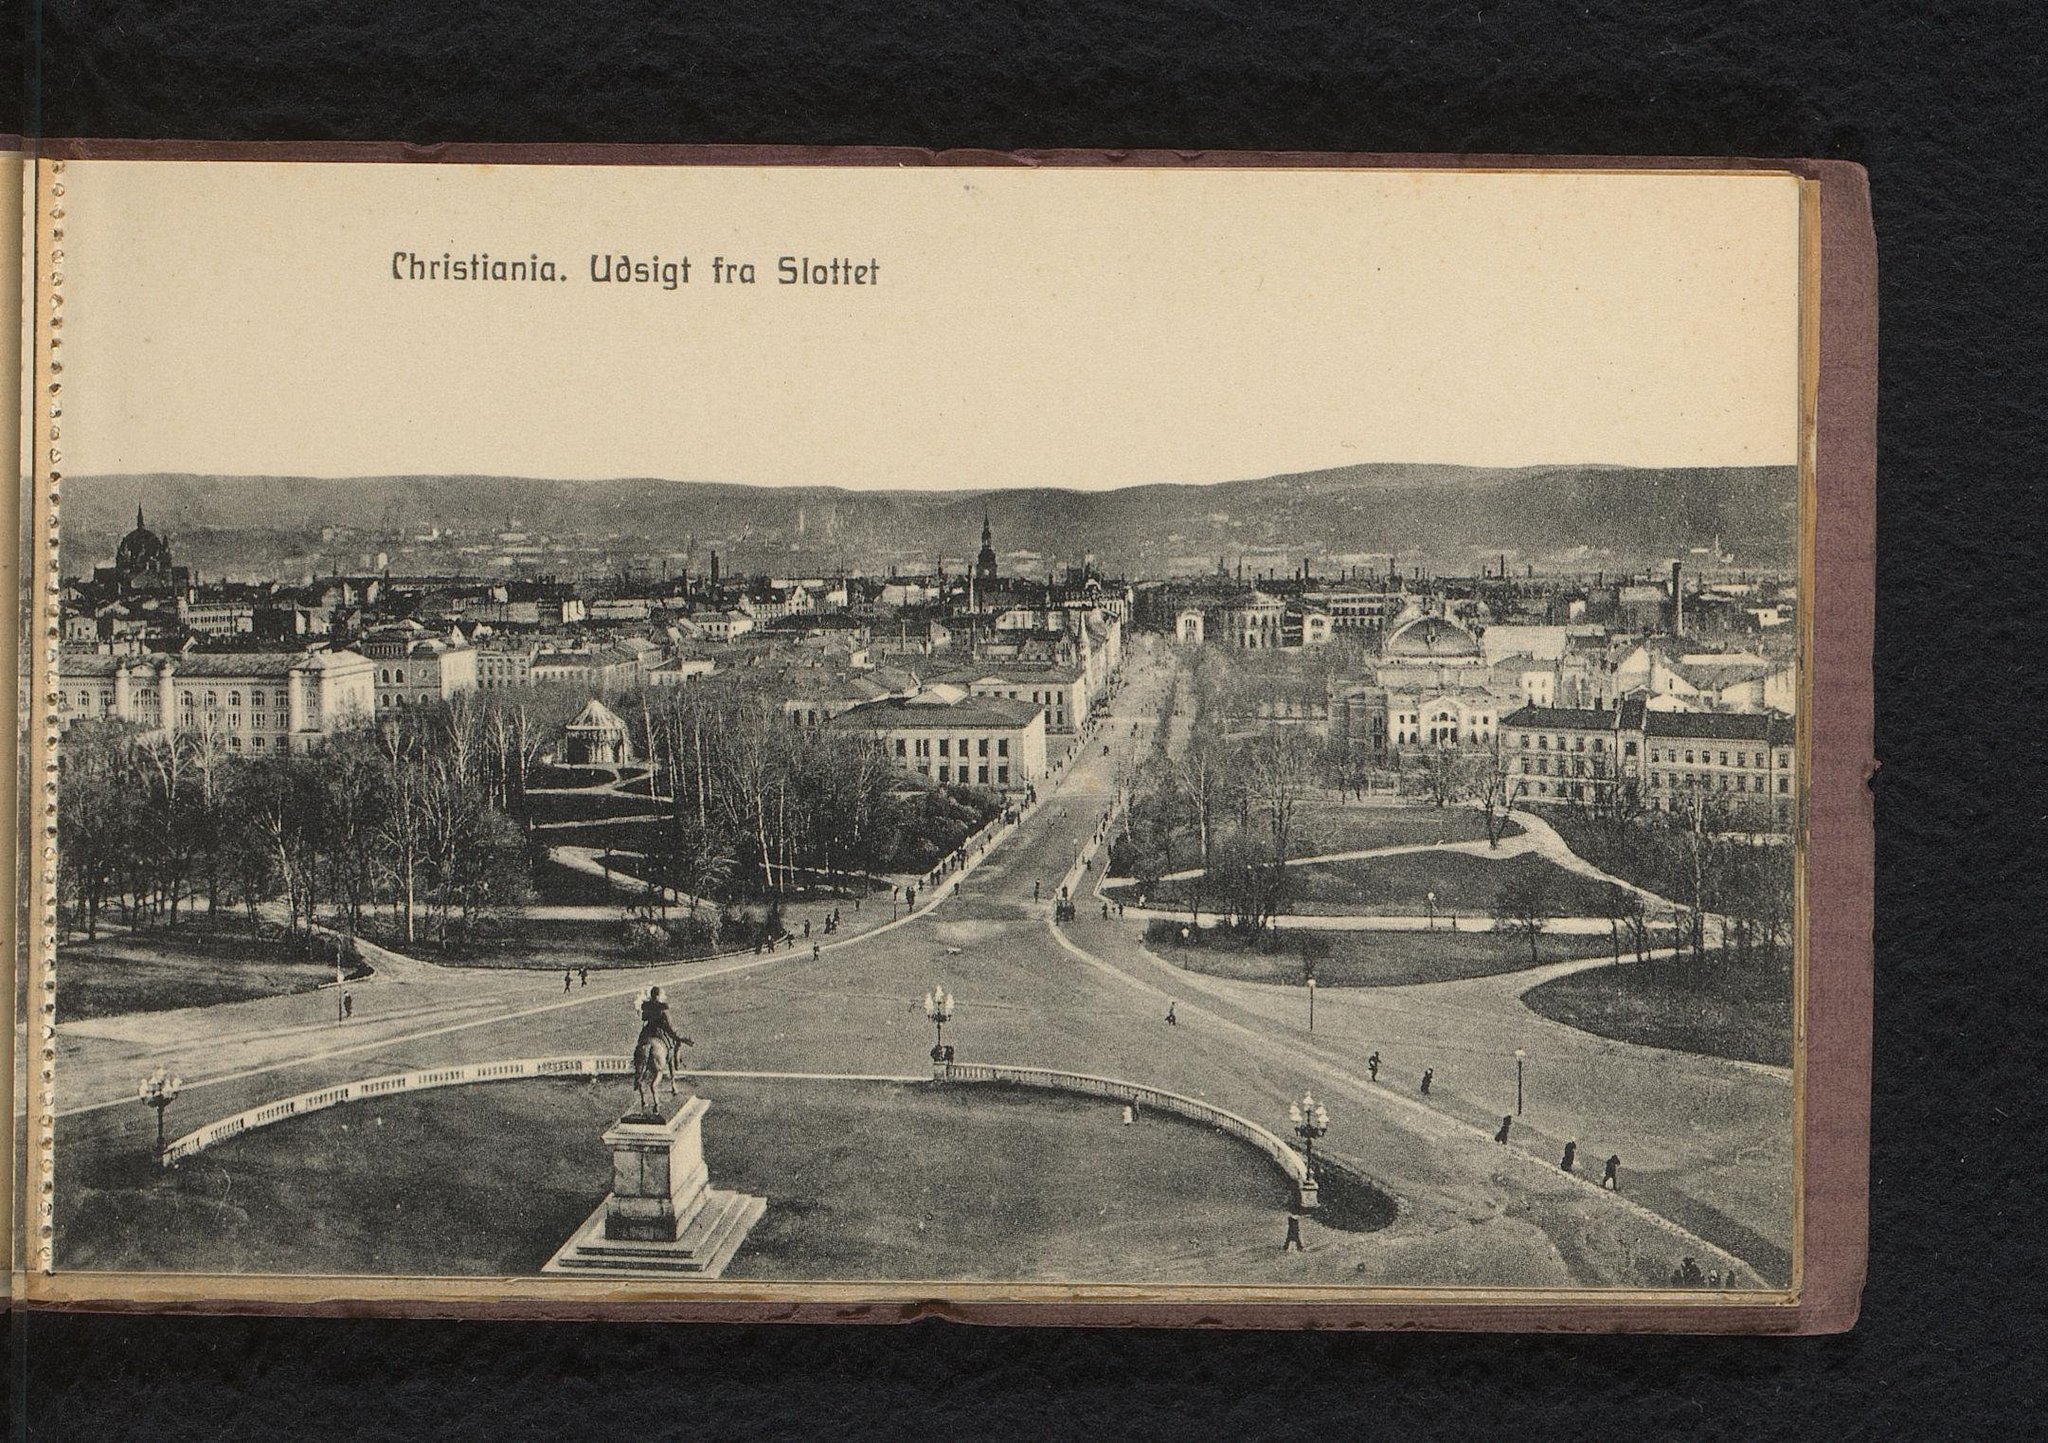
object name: ansichtkaart, prentbriefkaart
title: Christiania. Udsigt fra Slottet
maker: Anonymous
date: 1904-1925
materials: cardboard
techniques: photograph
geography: oslo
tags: palace, monument, statue, avenue, boulevard, promenade, esplanade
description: Prentbriefkaart maakt deel uit van een album.